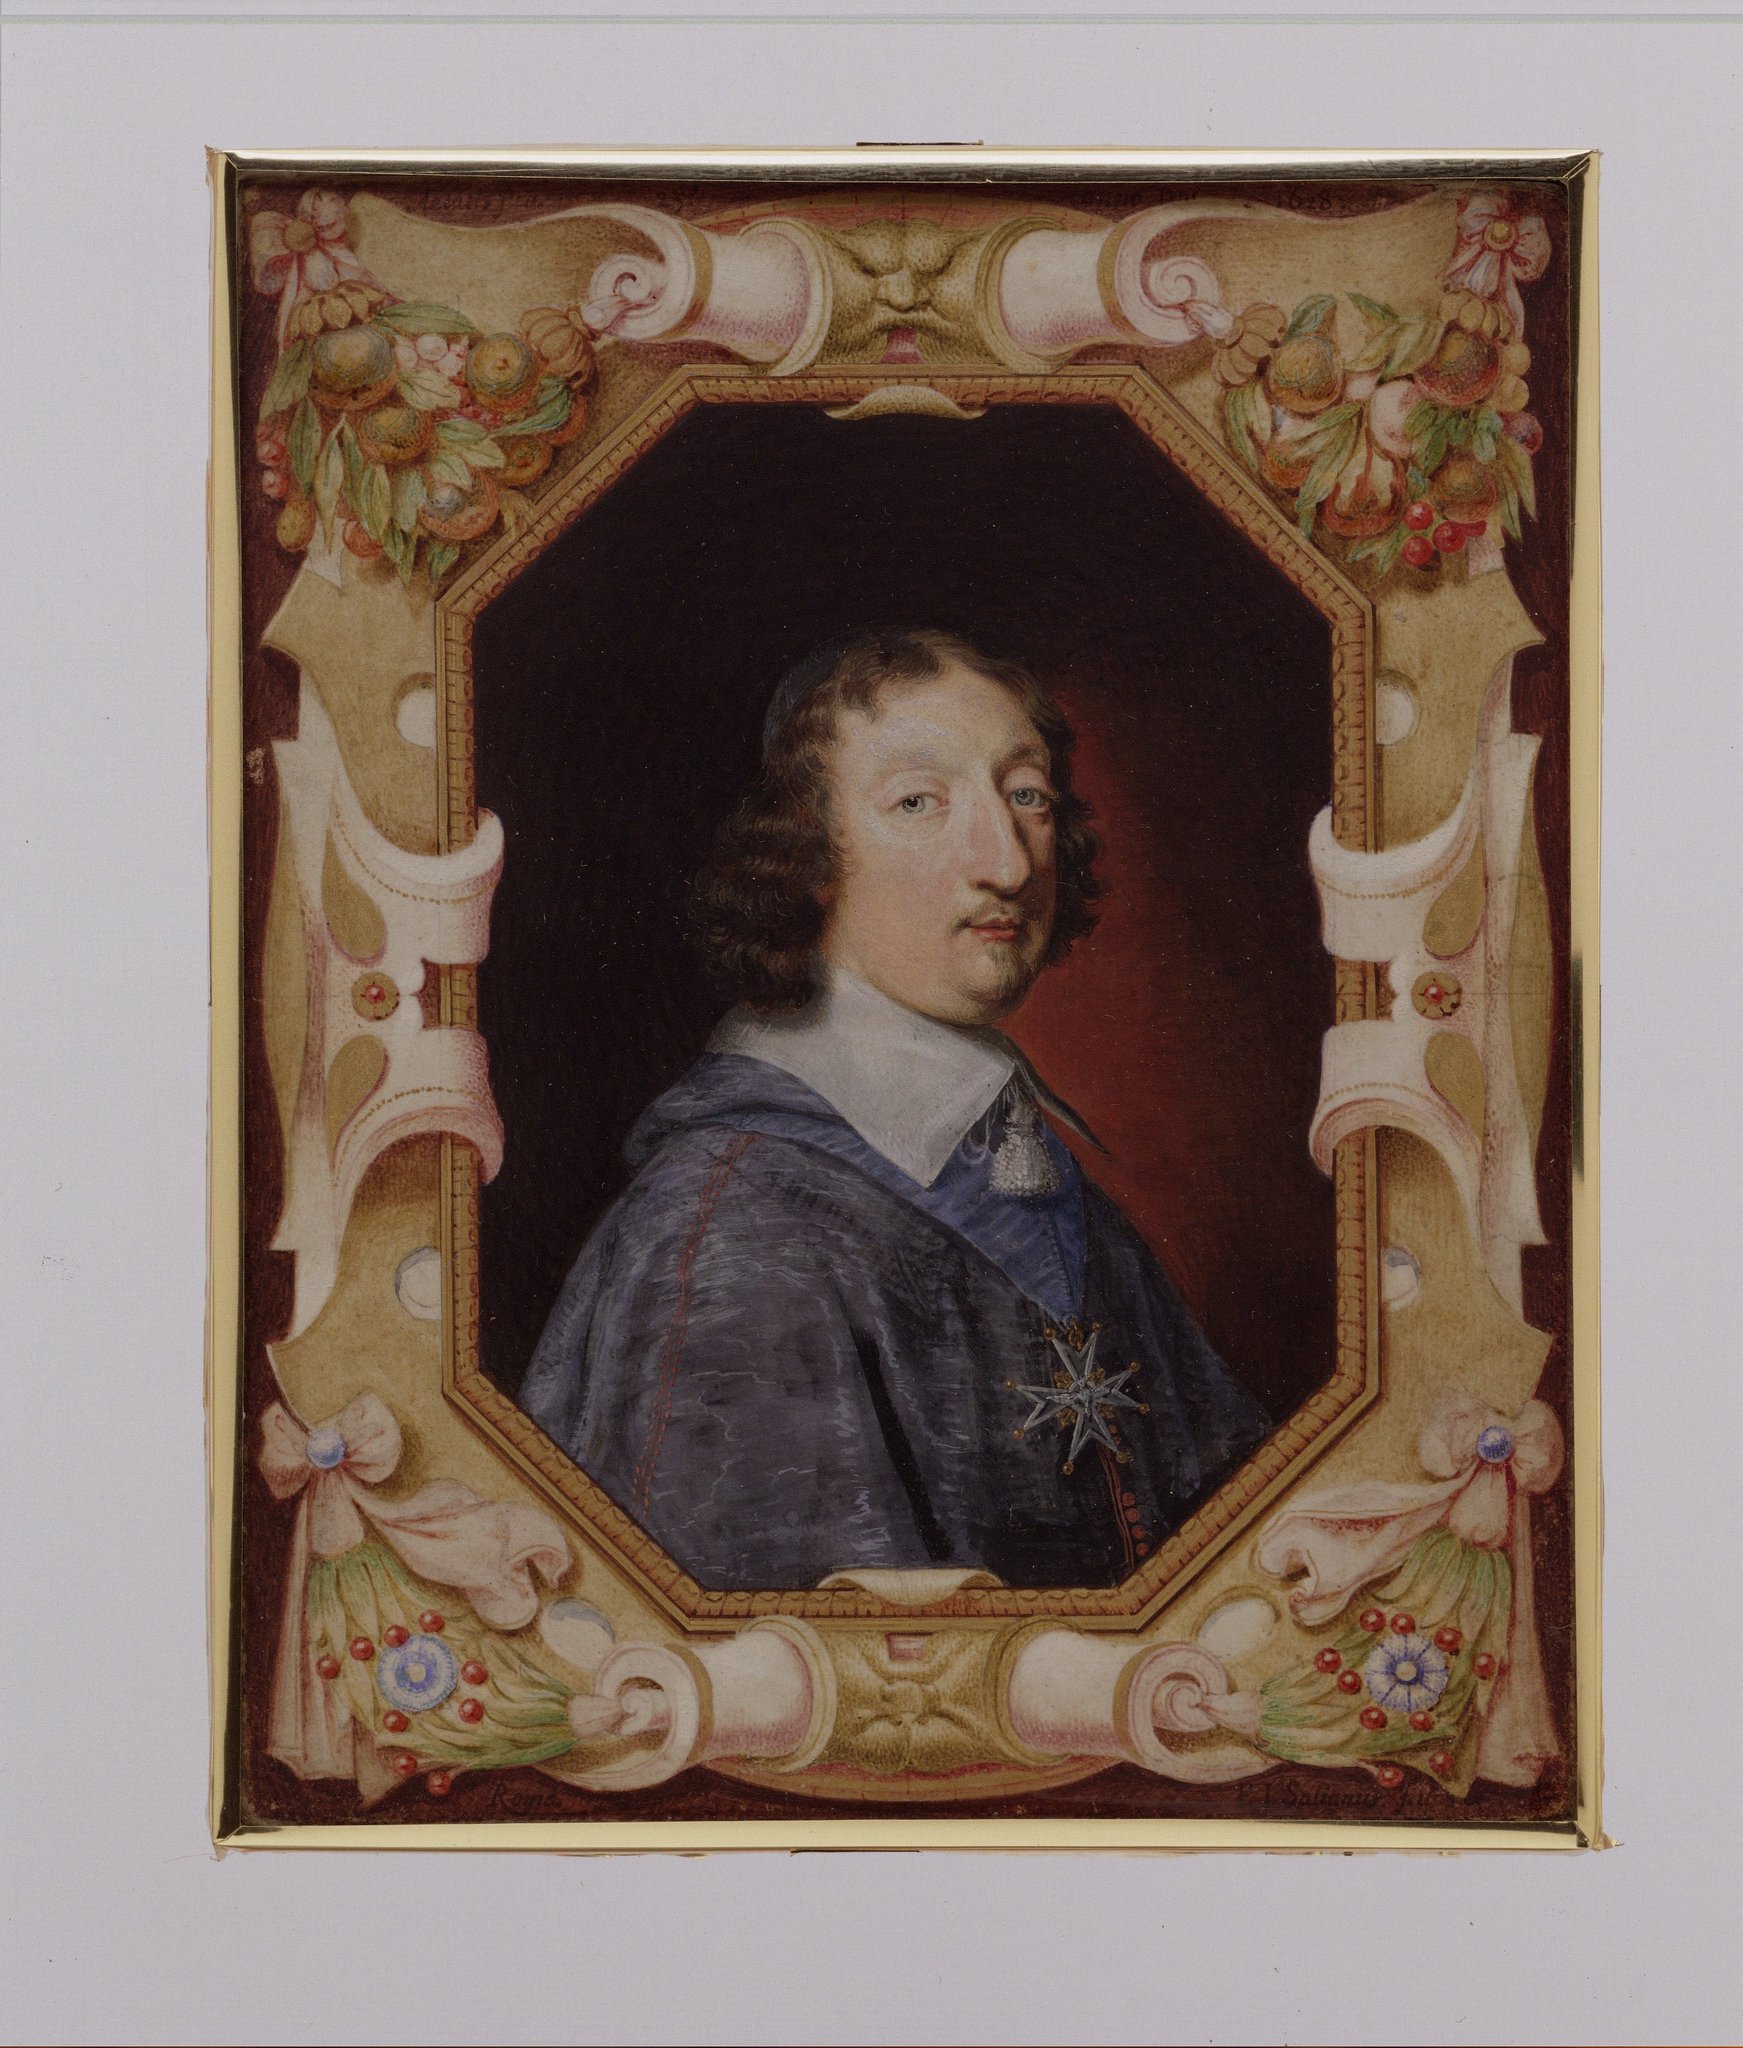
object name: painting, miniature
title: Gaspard de Daillon du Lude (ca. 1602–1676)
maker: jacques saillant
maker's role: artist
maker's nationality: french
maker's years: 1620-1638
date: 1628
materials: copper, parchment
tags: men,portraits